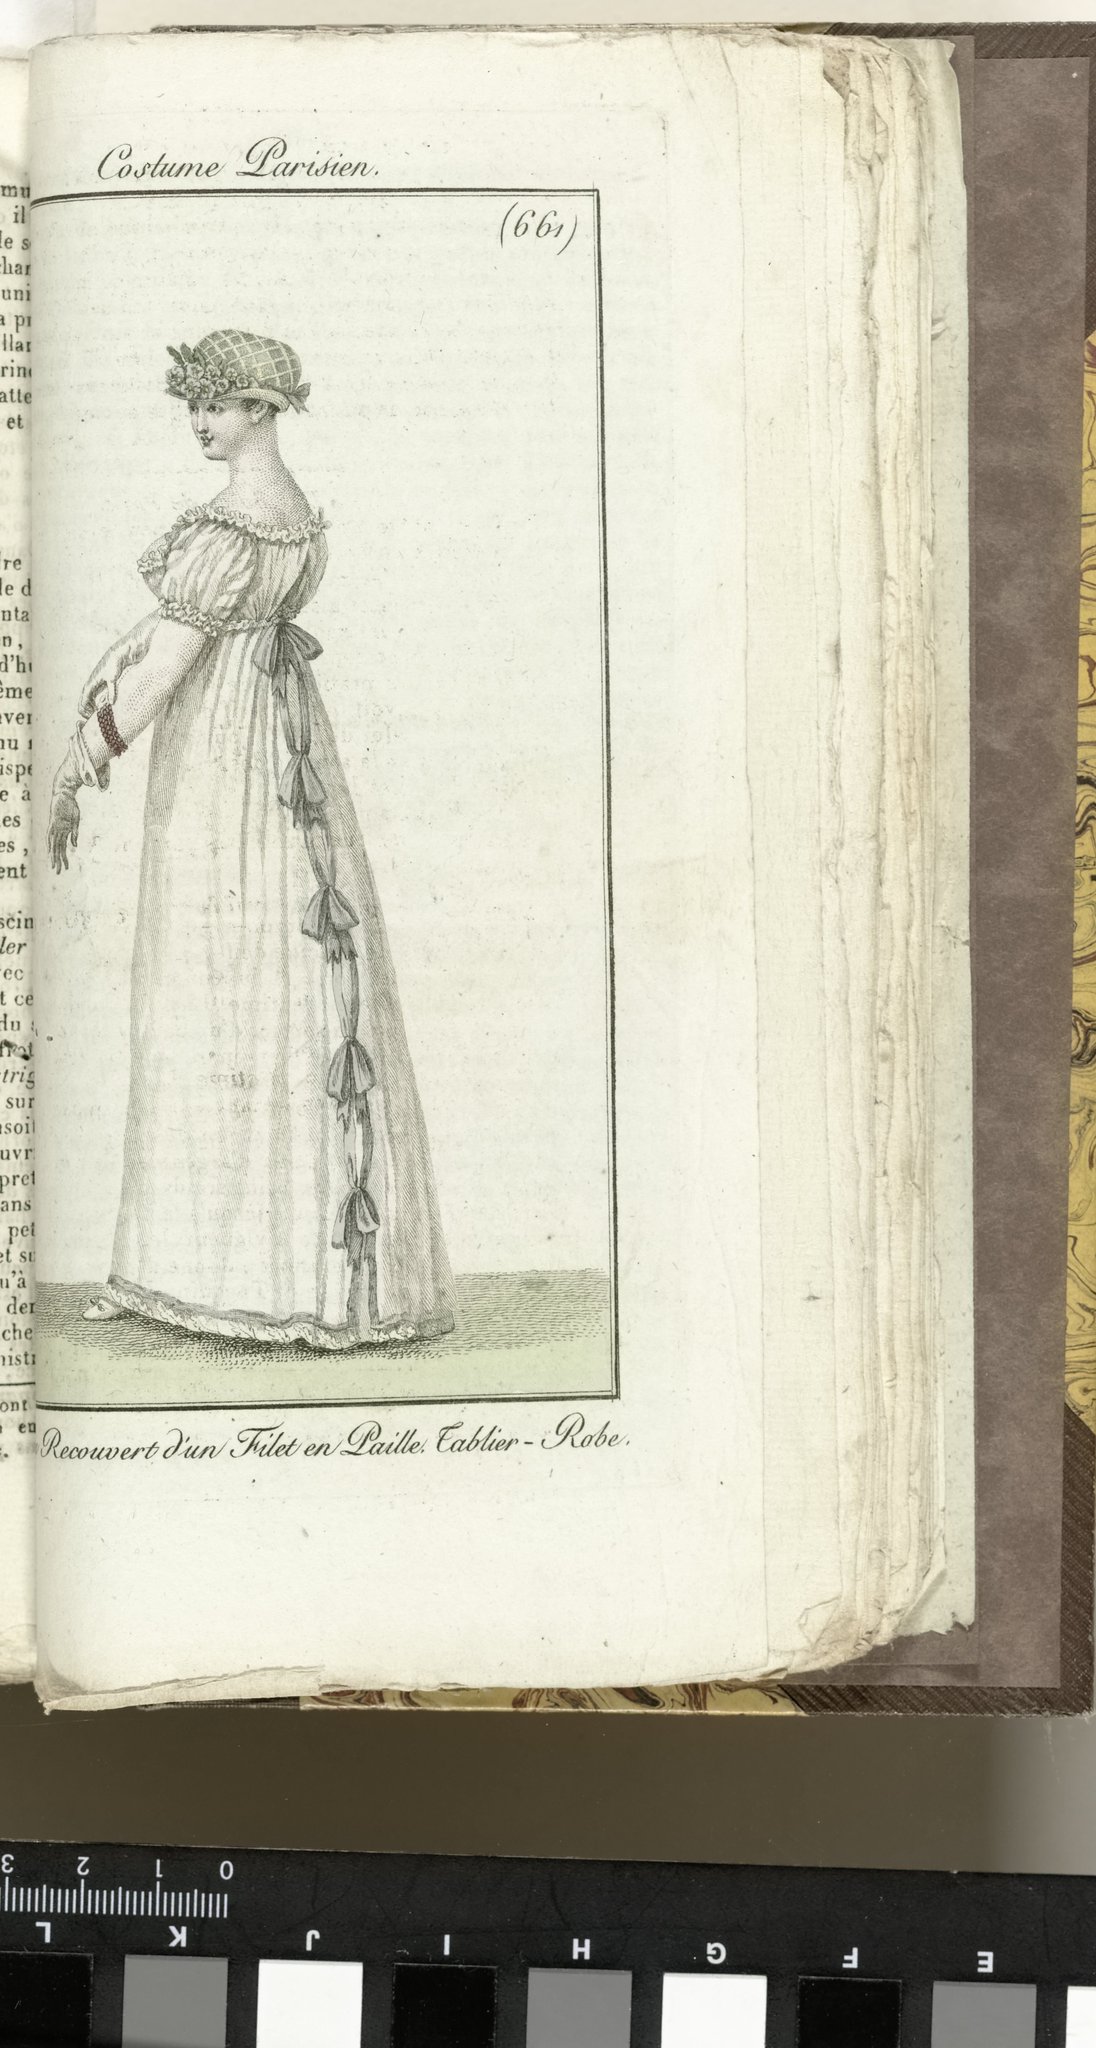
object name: fashion print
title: Journal des Dames et des Modes, Costume Parisien, 1805, An 13 (661) Chapeau Recouvert d'un Filet en Paille...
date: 1805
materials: paper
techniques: engraving, hand coloring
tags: gloves, mittens (long gloves) (+ women's clothes), fashion plates, head-gear: hat (+ women's clothes), fan (+ women's clothes)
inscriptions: title: ‘Chapeau Recouvert d'un Filet en Paille. Tablier-Robe’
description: Vrouw naar links, in Tablier-Robe met strikken op de rug. Lange handschoenen en armband. Hoedje overtrokken met banden van stro.